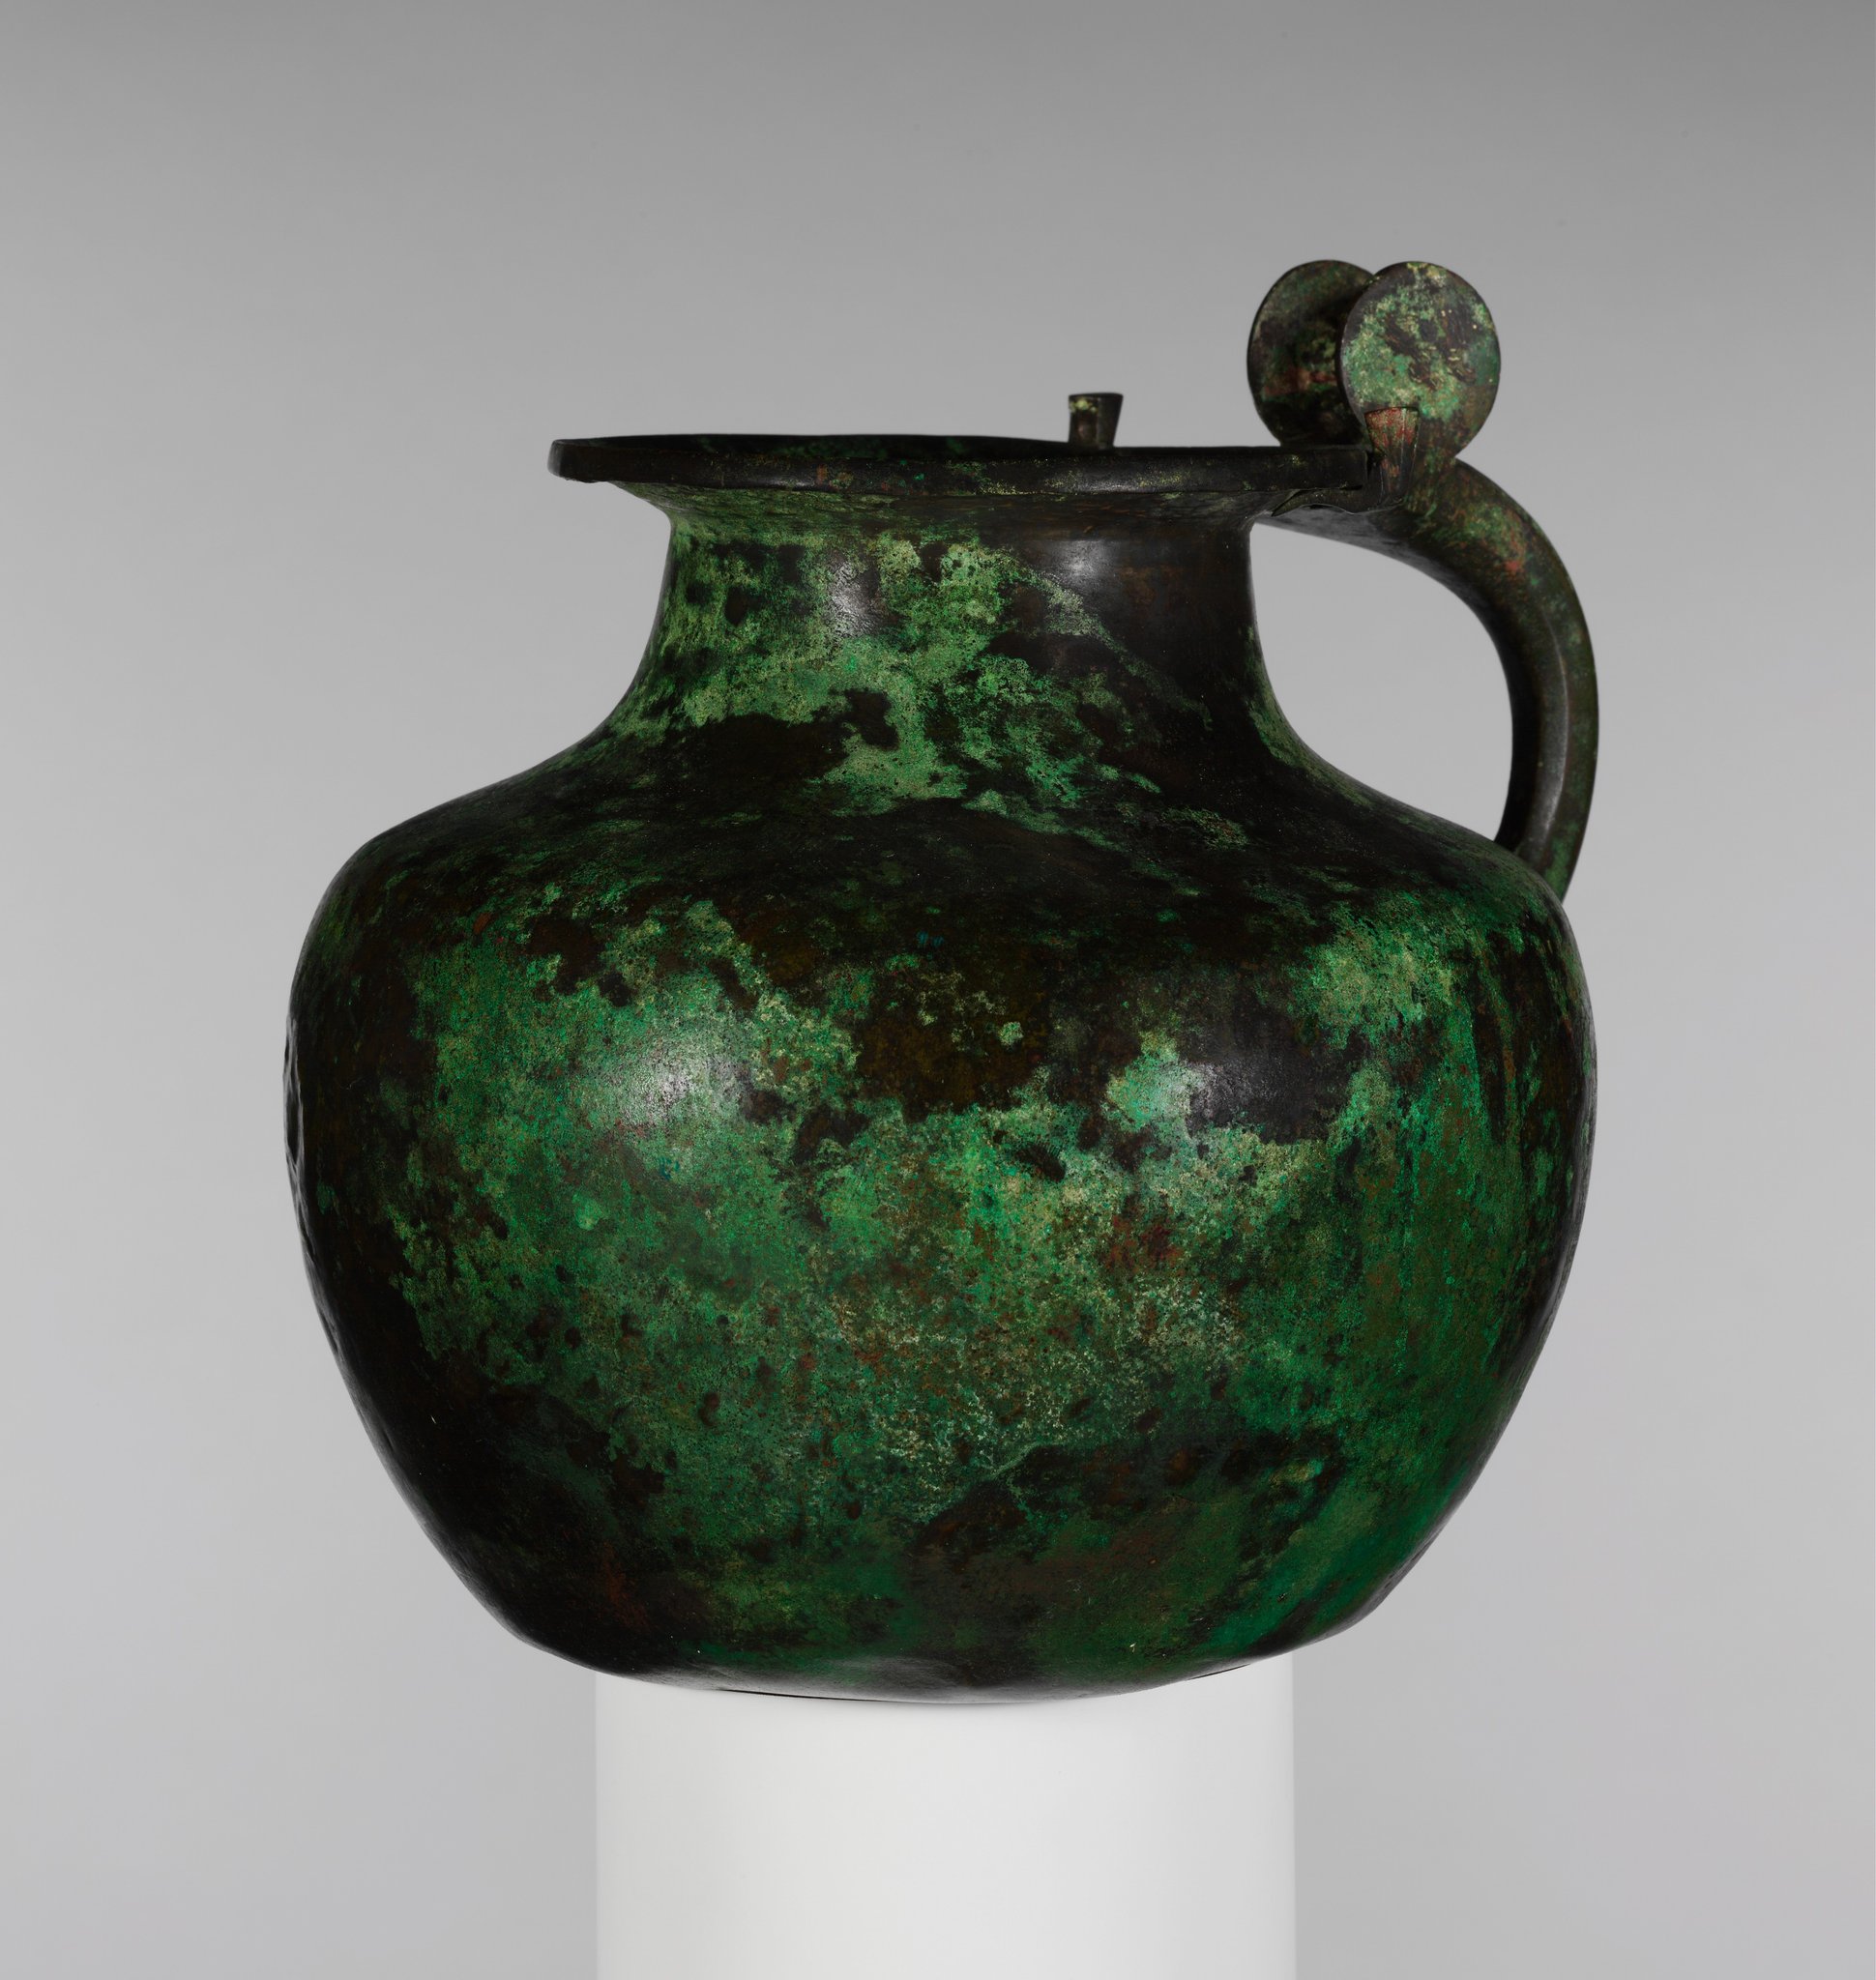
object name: oinochoe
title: Bronze oinochoe (jug)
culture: greek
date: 400-301 BCE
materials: bronze